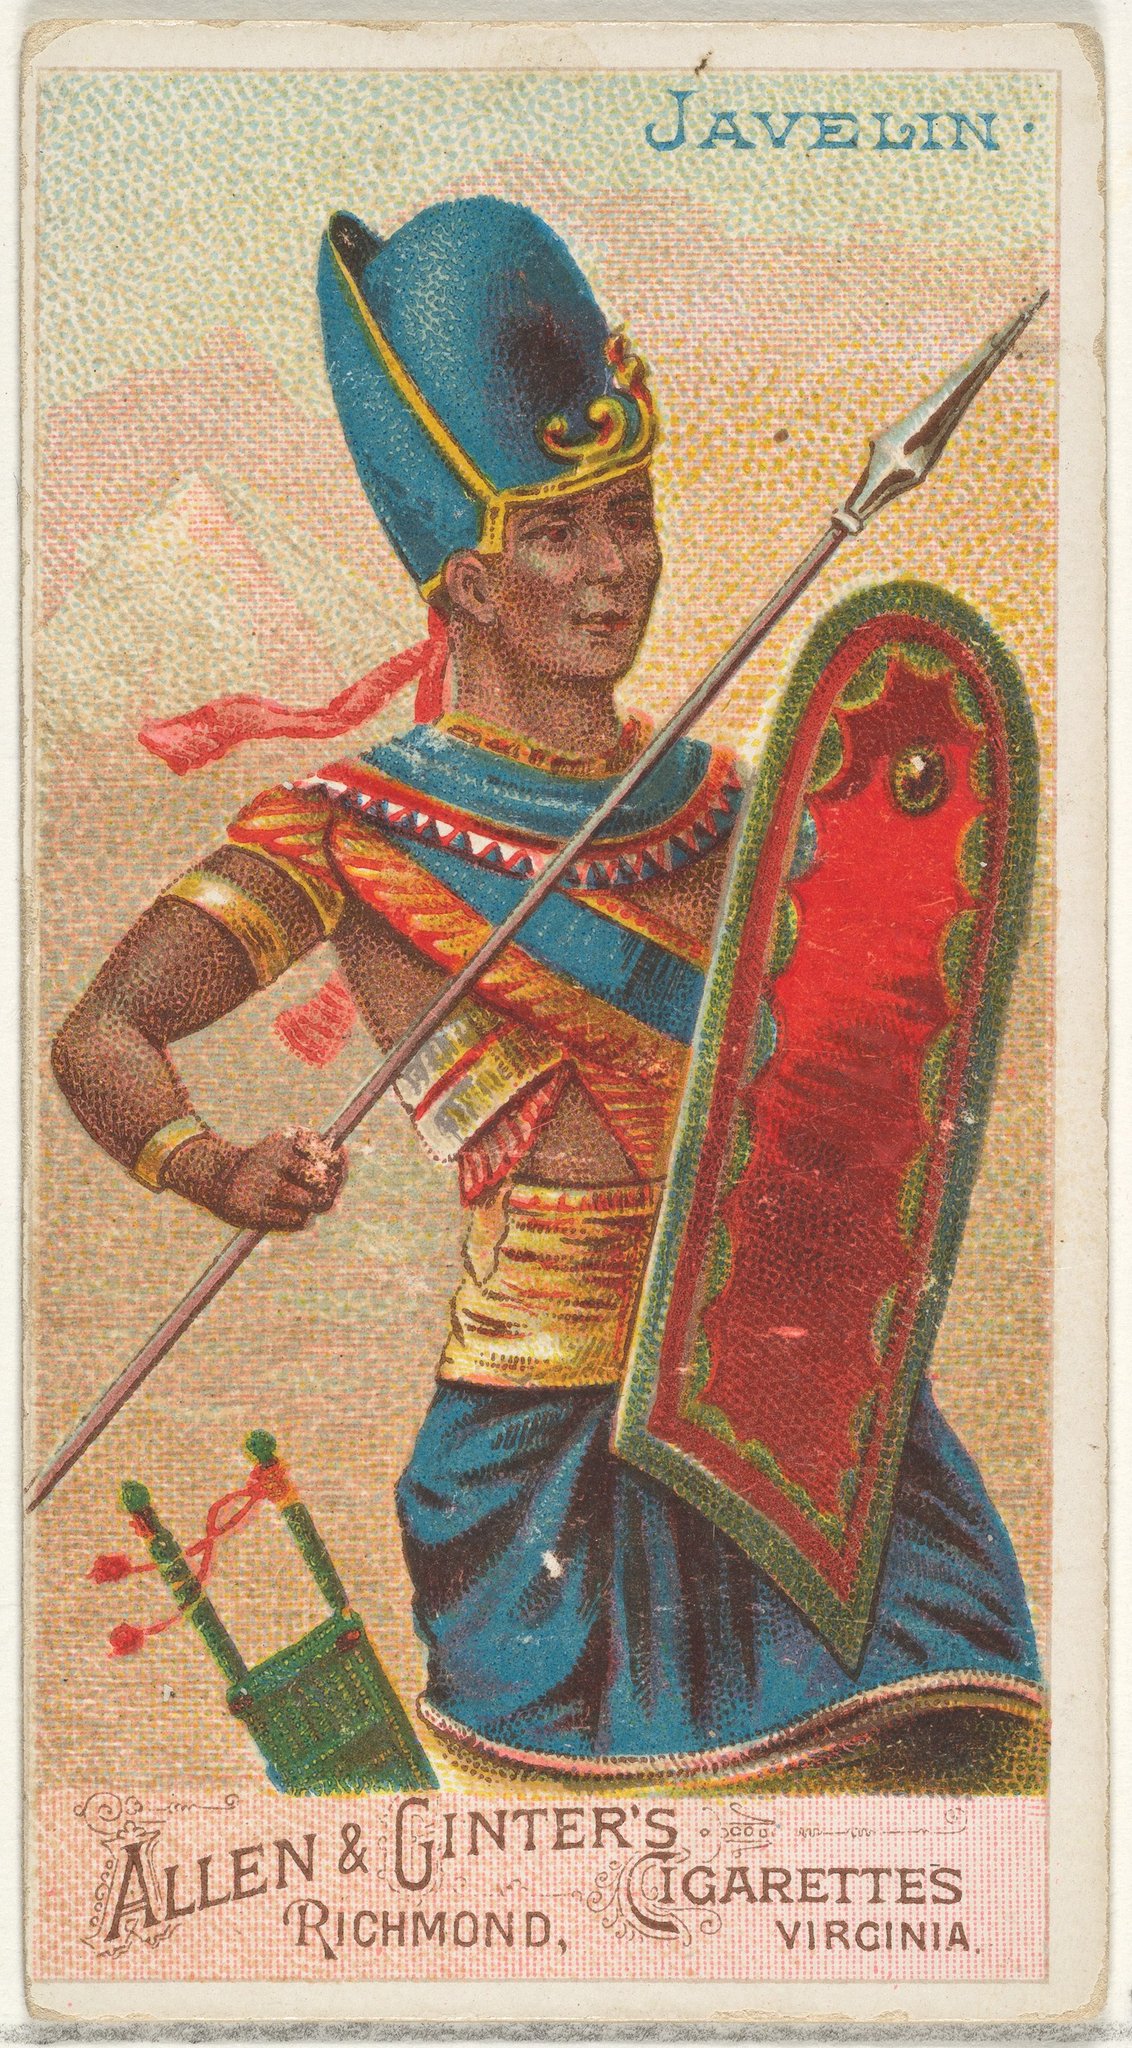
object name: print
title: Javelin, from the Arms of All Nations series (N3) for Allen & Ginter Cigarettes Brands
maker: allen & ginter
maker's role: publisher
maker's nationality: american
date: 1887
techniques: color lithograph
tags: shields,spears,men